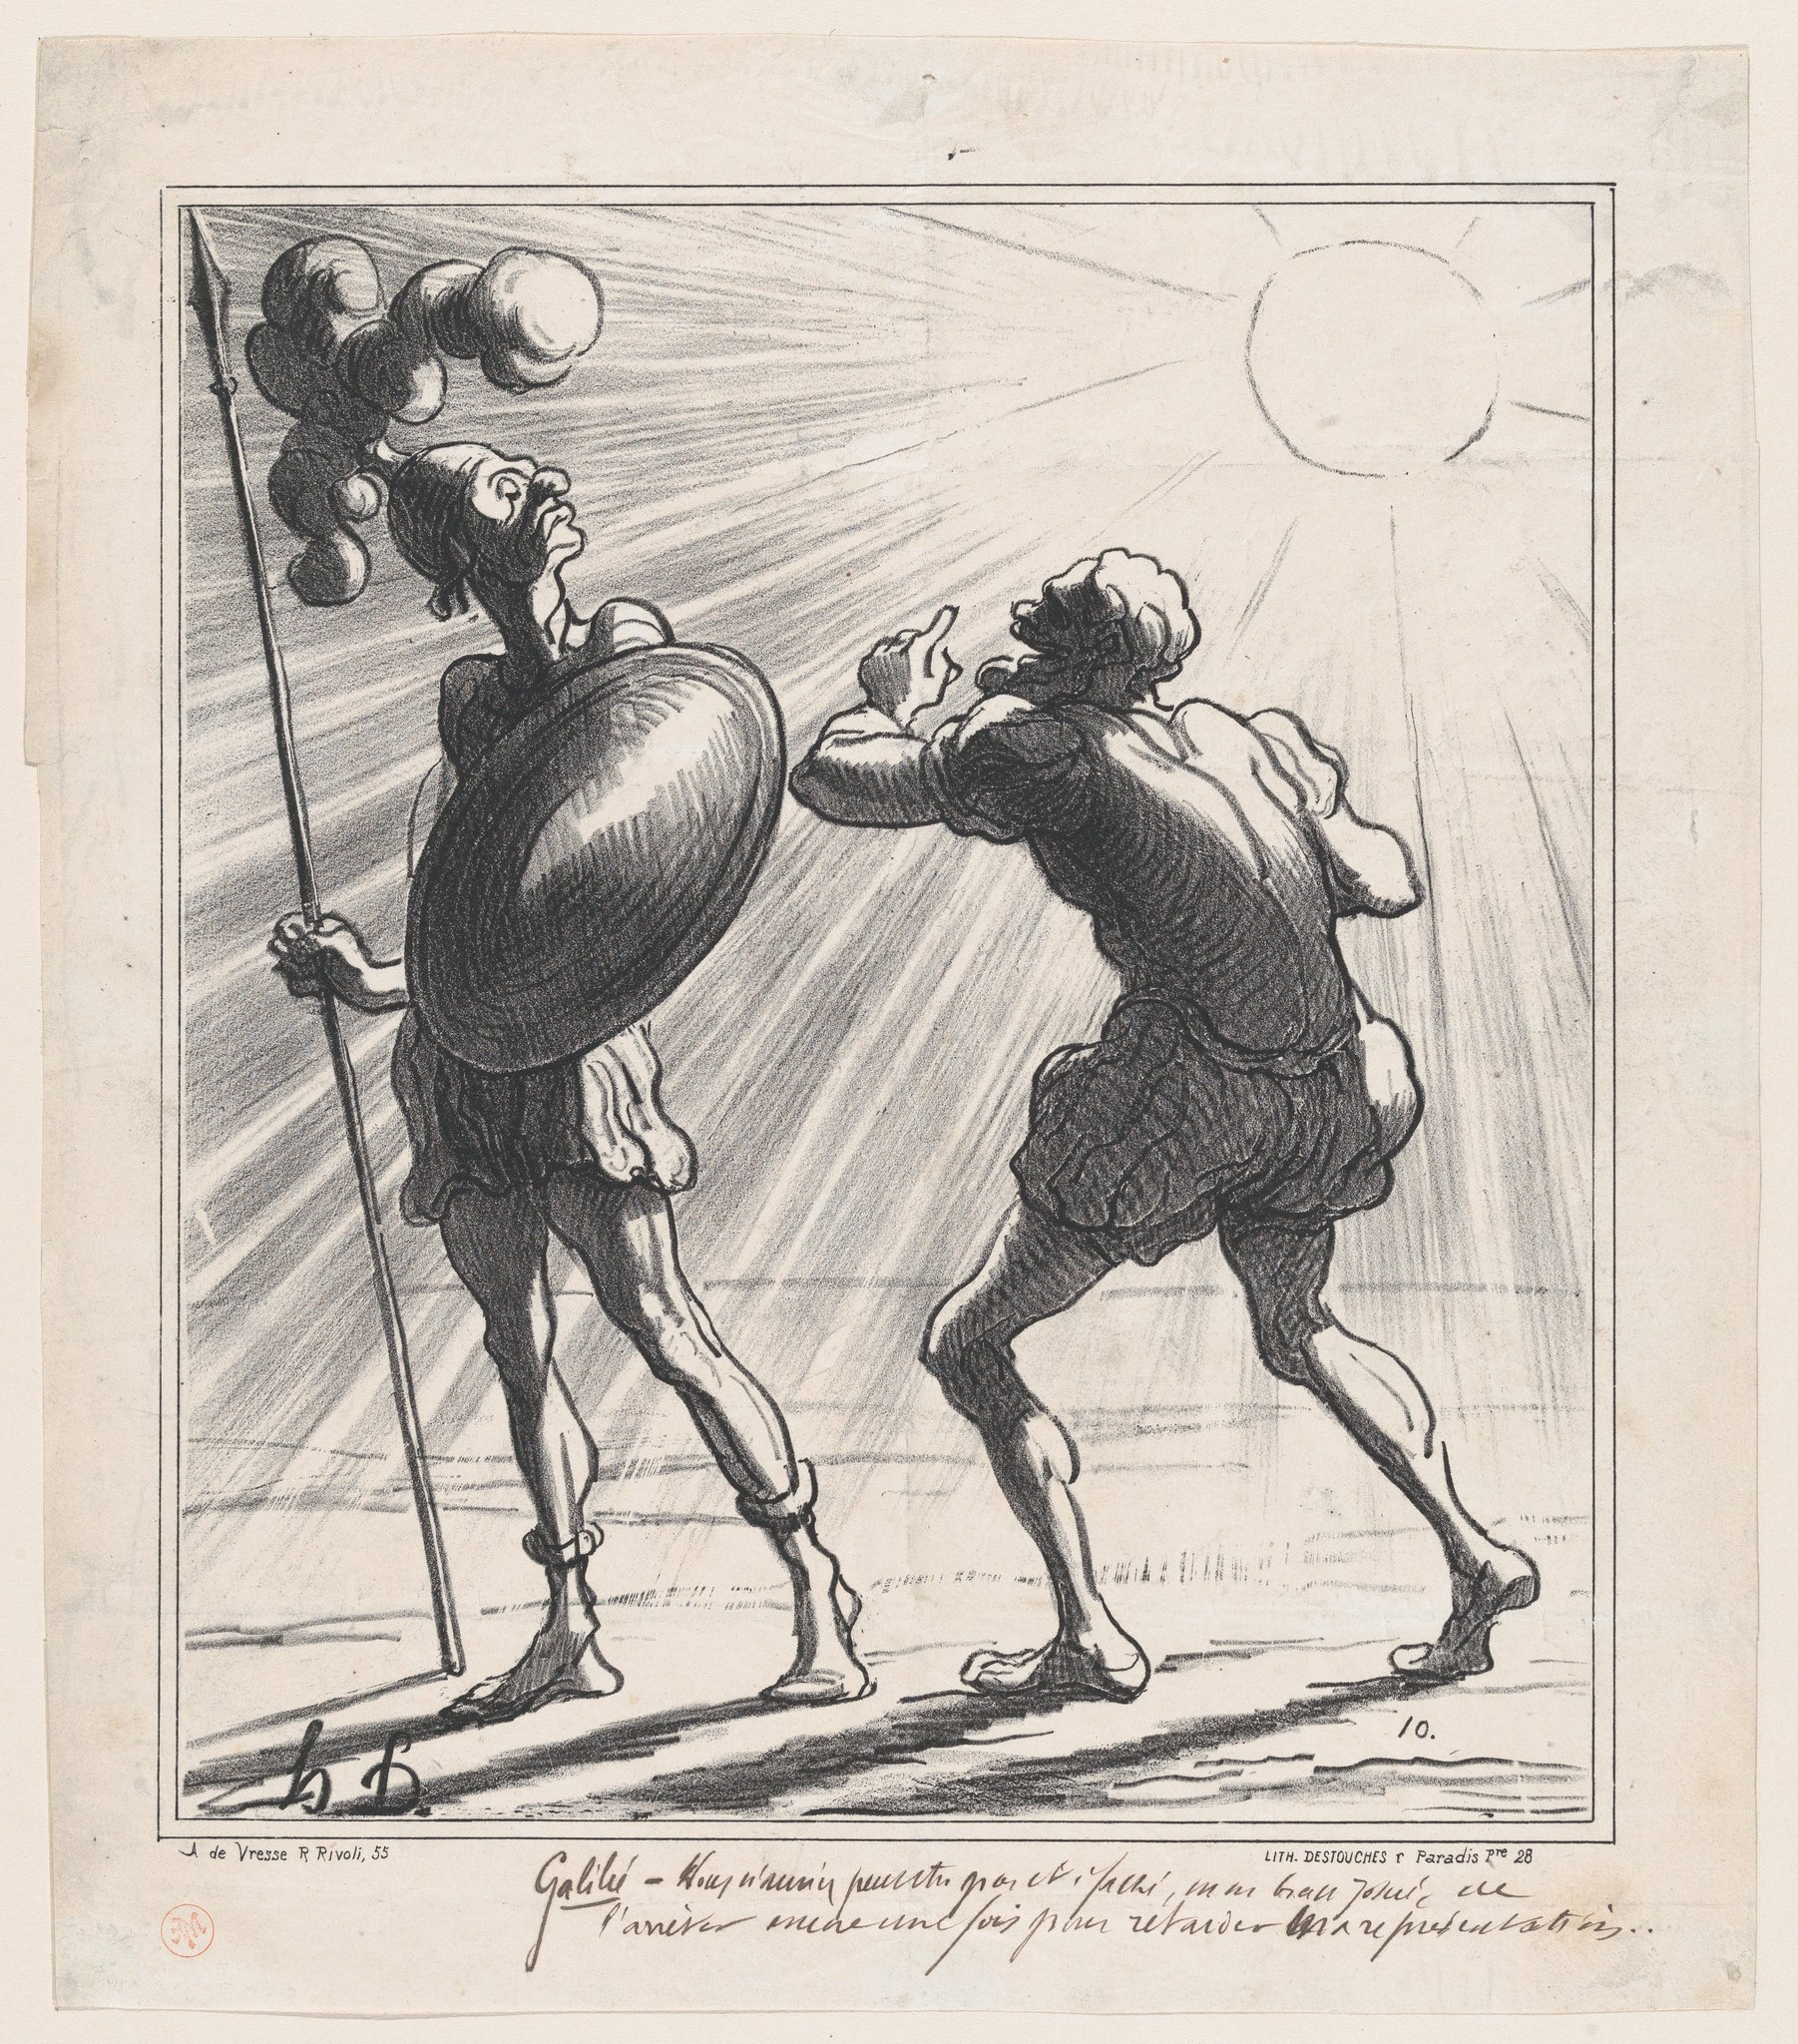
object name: print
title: Galileo: You wouldn't be annoyed, my good Joshua, to stop the sun once again for the sake of my show, from 'News of the day,' published in "Le Charivari"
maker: honoré daumier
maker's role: artist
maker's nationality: french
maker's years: 1808-1879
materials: ink, paper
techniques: lithograph, pen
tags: soldiers,shields,spears,men,sun